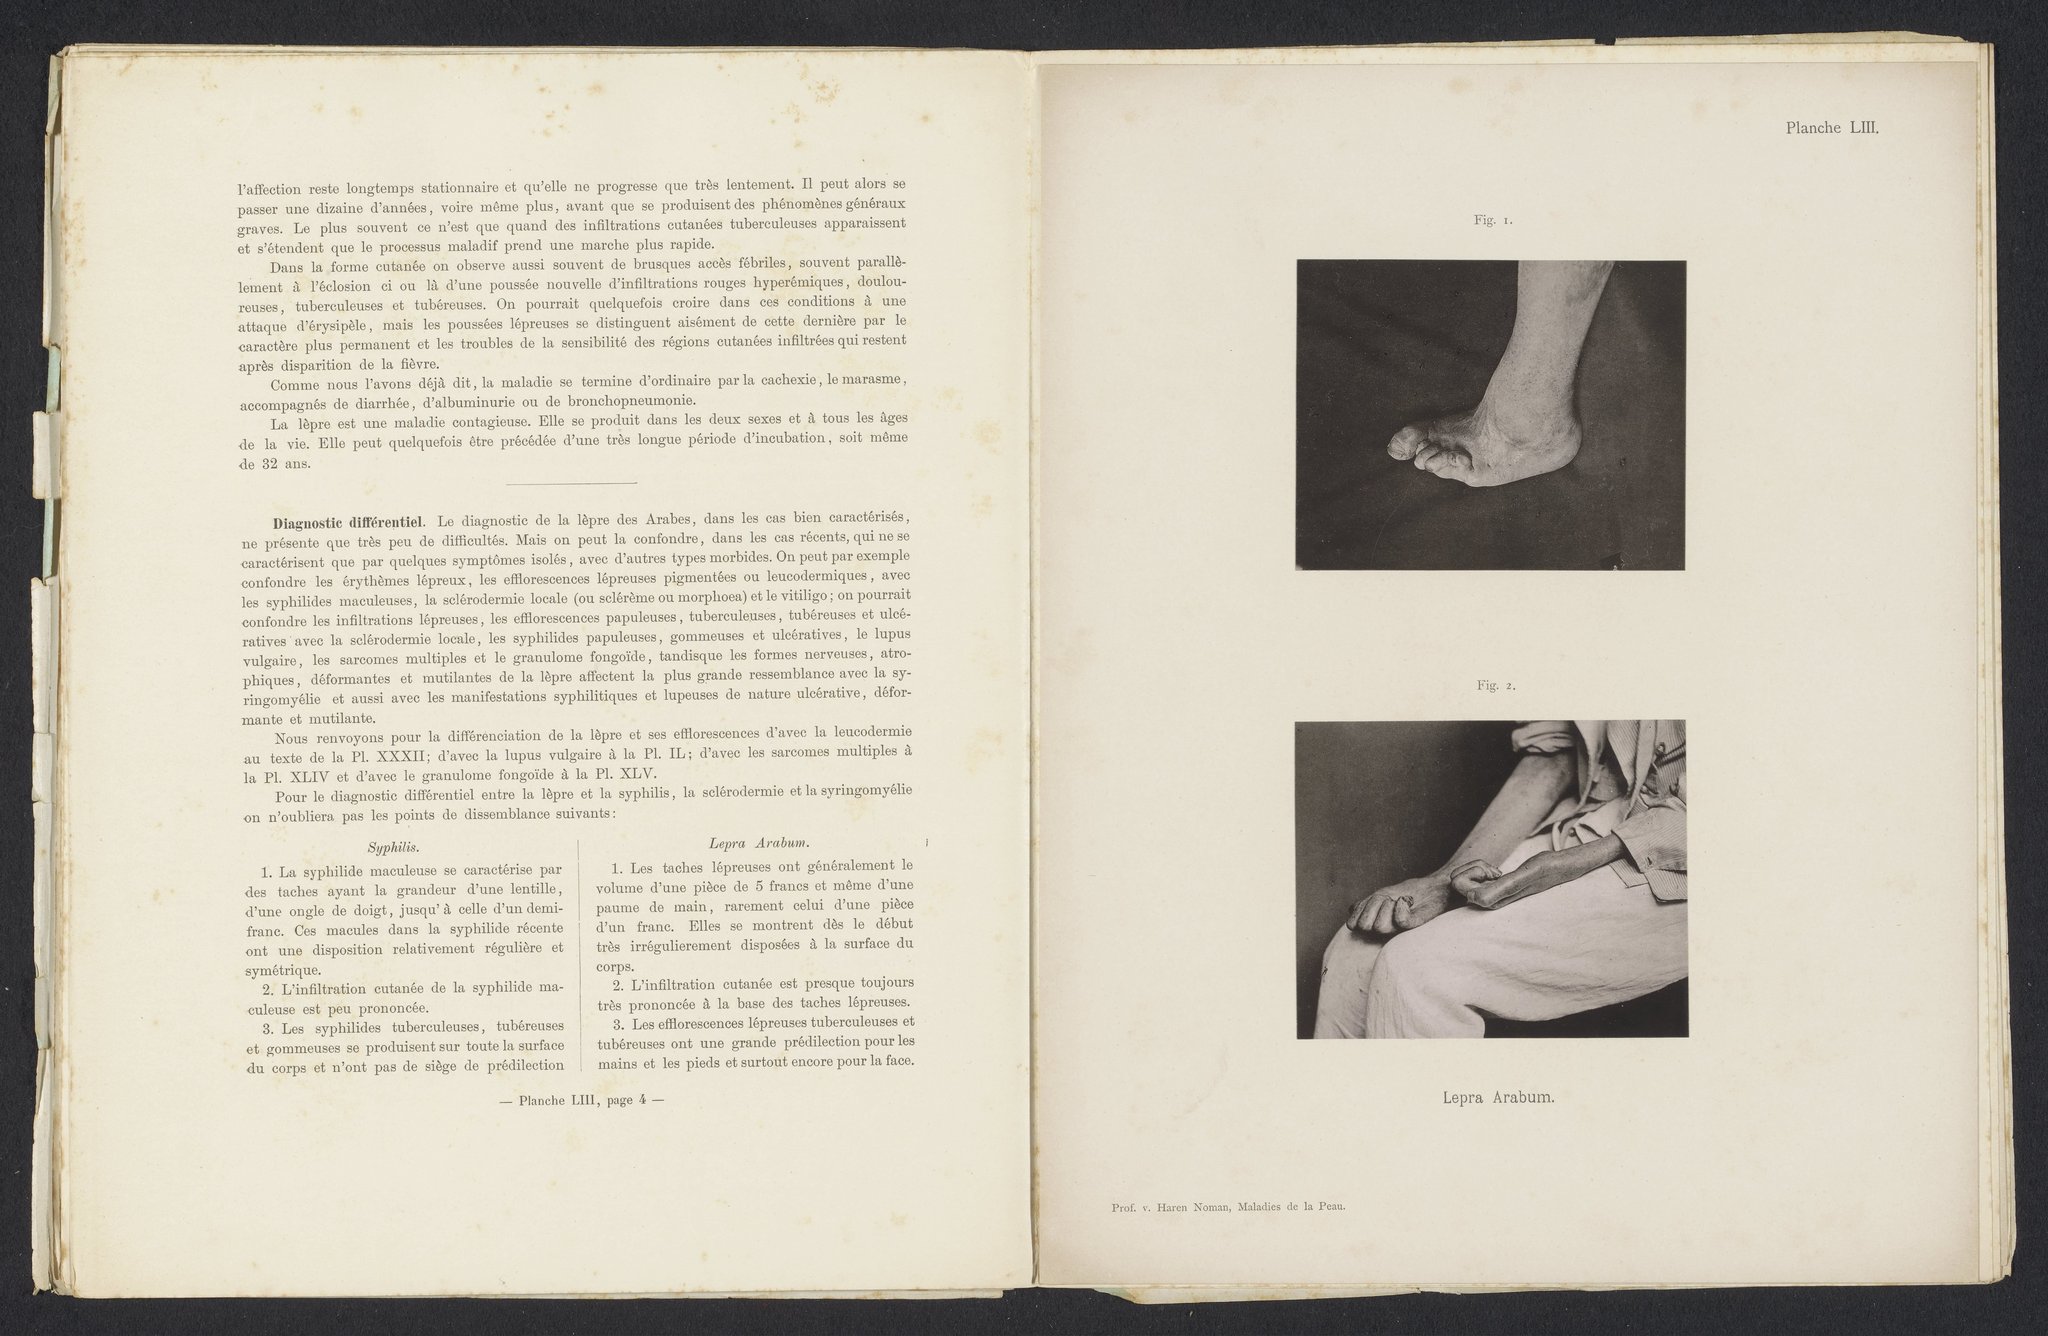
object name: photomechanical print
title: Patiënten lijdend aan de huidziekte 'lepra arabum'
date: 1885-1895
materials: paper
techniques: photograph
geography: haarlem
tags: skin and venereal diseases, arms, hand, foot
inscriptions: number: ‘Planche LIII. / Fig. 1. / Fig. 2’